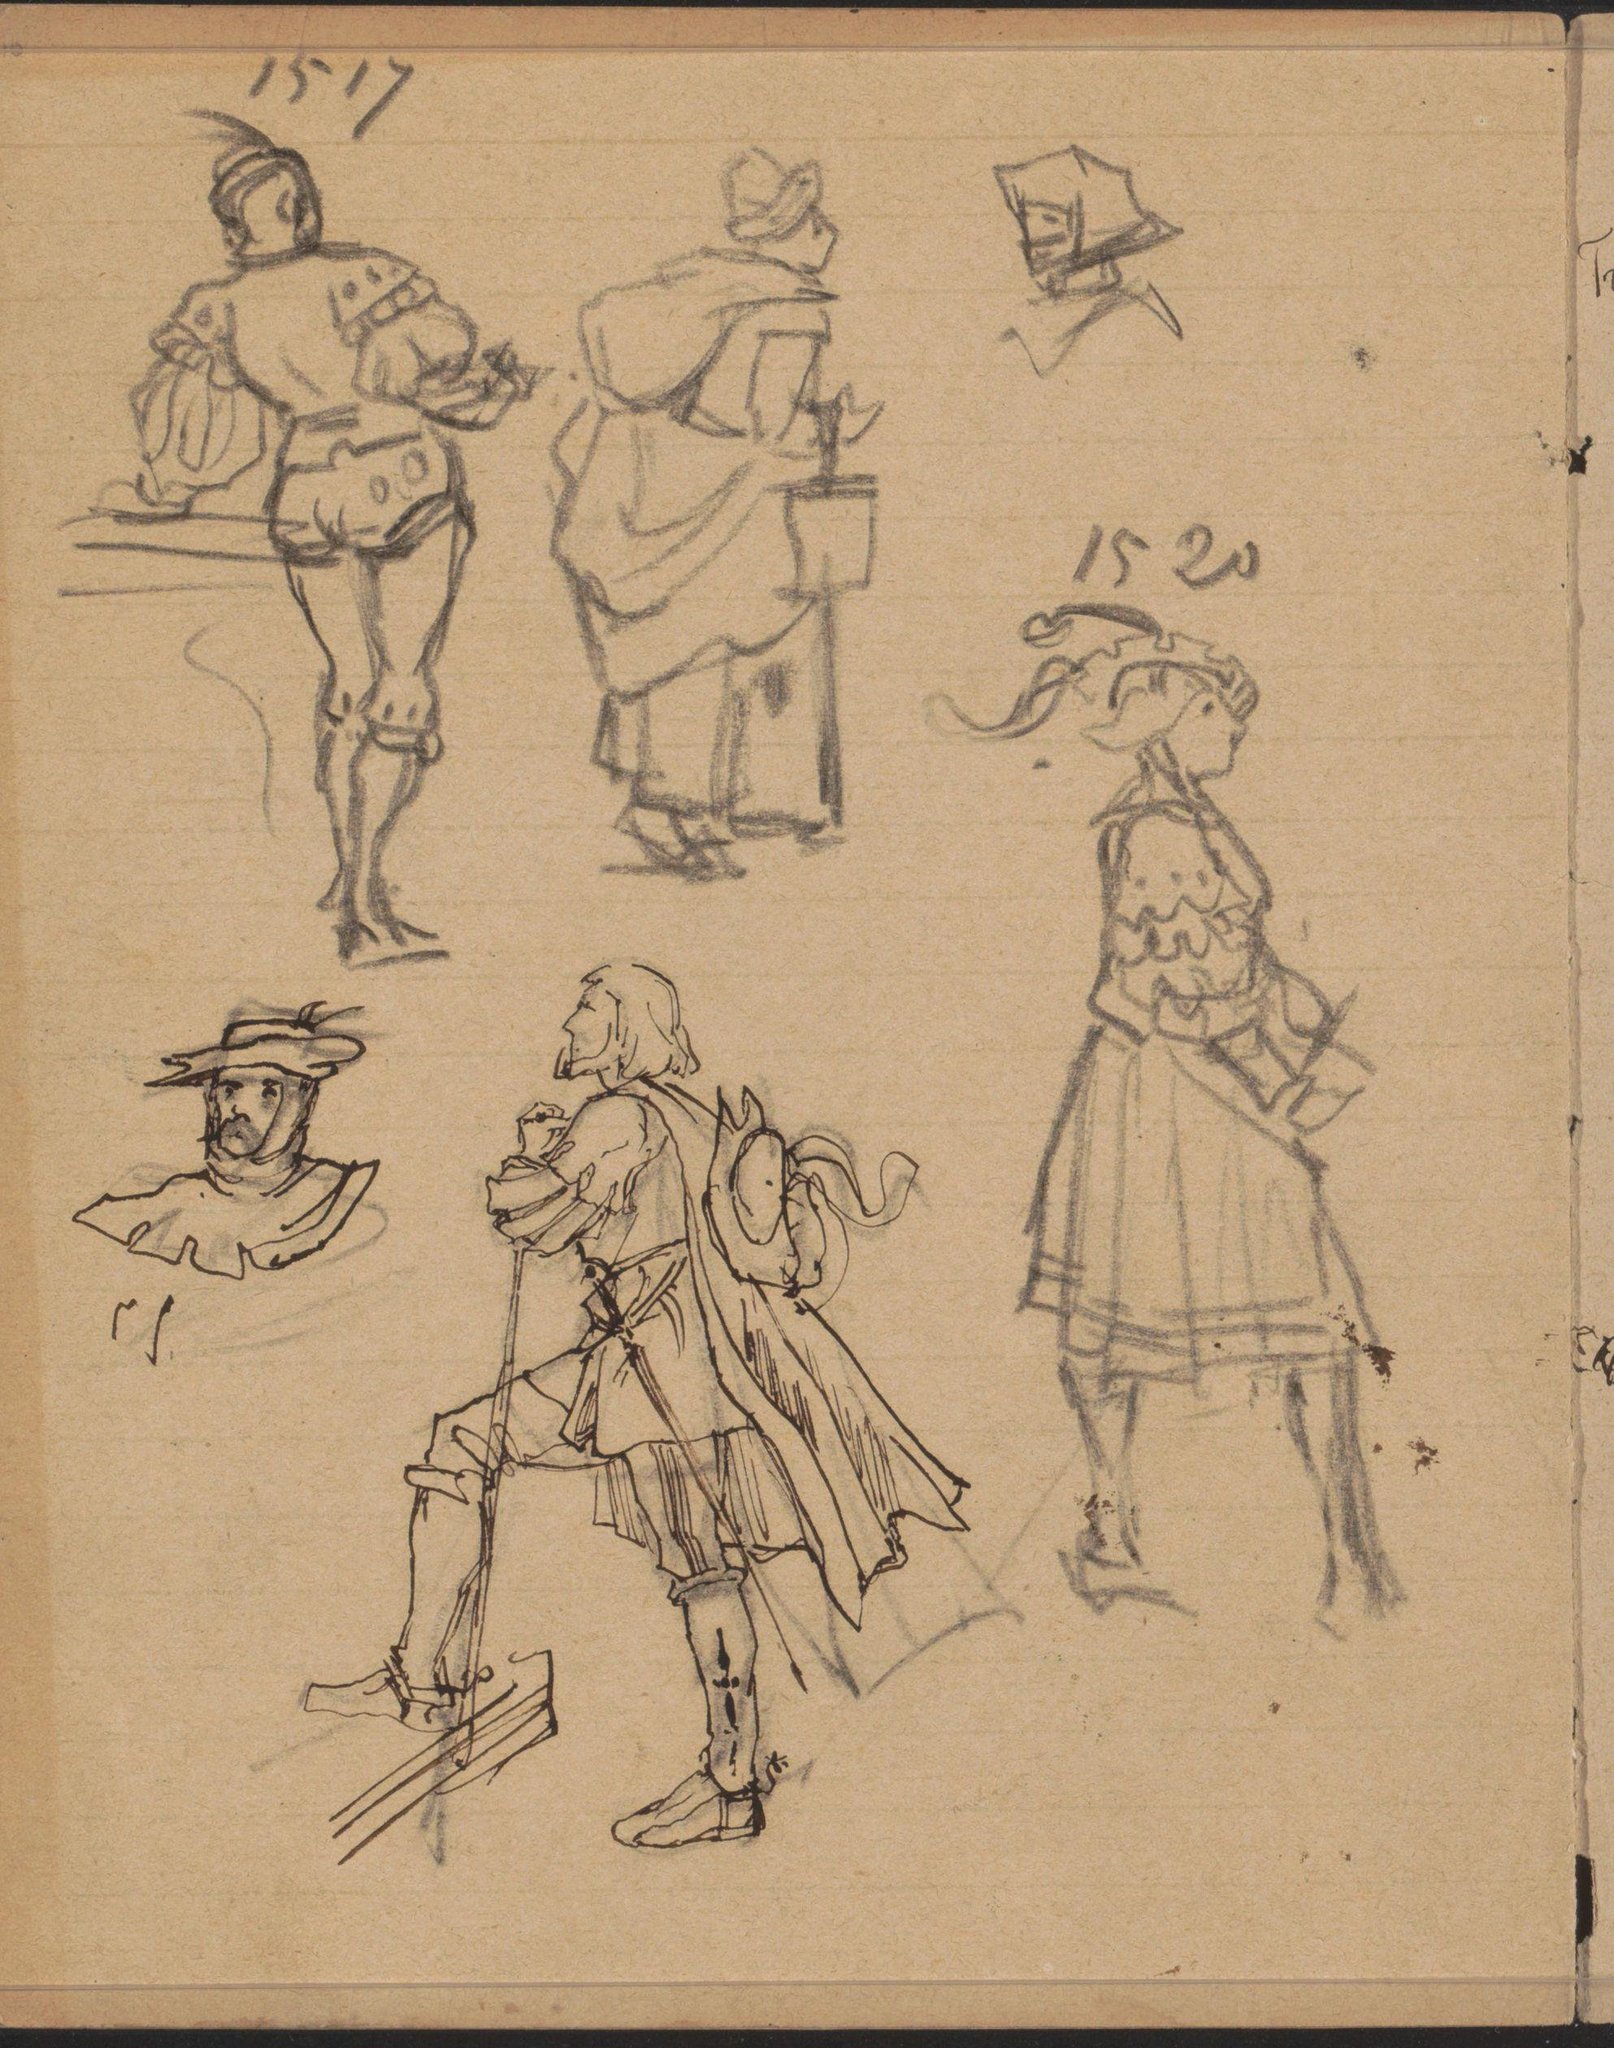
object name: sketchbook leaf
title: Figuren in kostuums uit 1517-1520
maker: marius bauer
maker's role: draughtsman, print maker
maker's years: 1867-1932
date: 1885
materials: charcoal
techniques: pen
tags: adult woman, walking-stick, staff, adult man, historical costume, pilgrim's dress and attributes, e.g. flask, hat, mantle, staff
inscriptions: annotation: ‘1517/ 1520’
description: De figuren dragen onder andere ridderkostuum en een pelgrimskostuum met wandelstok. Tevens een studie van een vrouw in werkkleding met een emmer. Pagina 10 uit een schetsboek met 6 bladen.